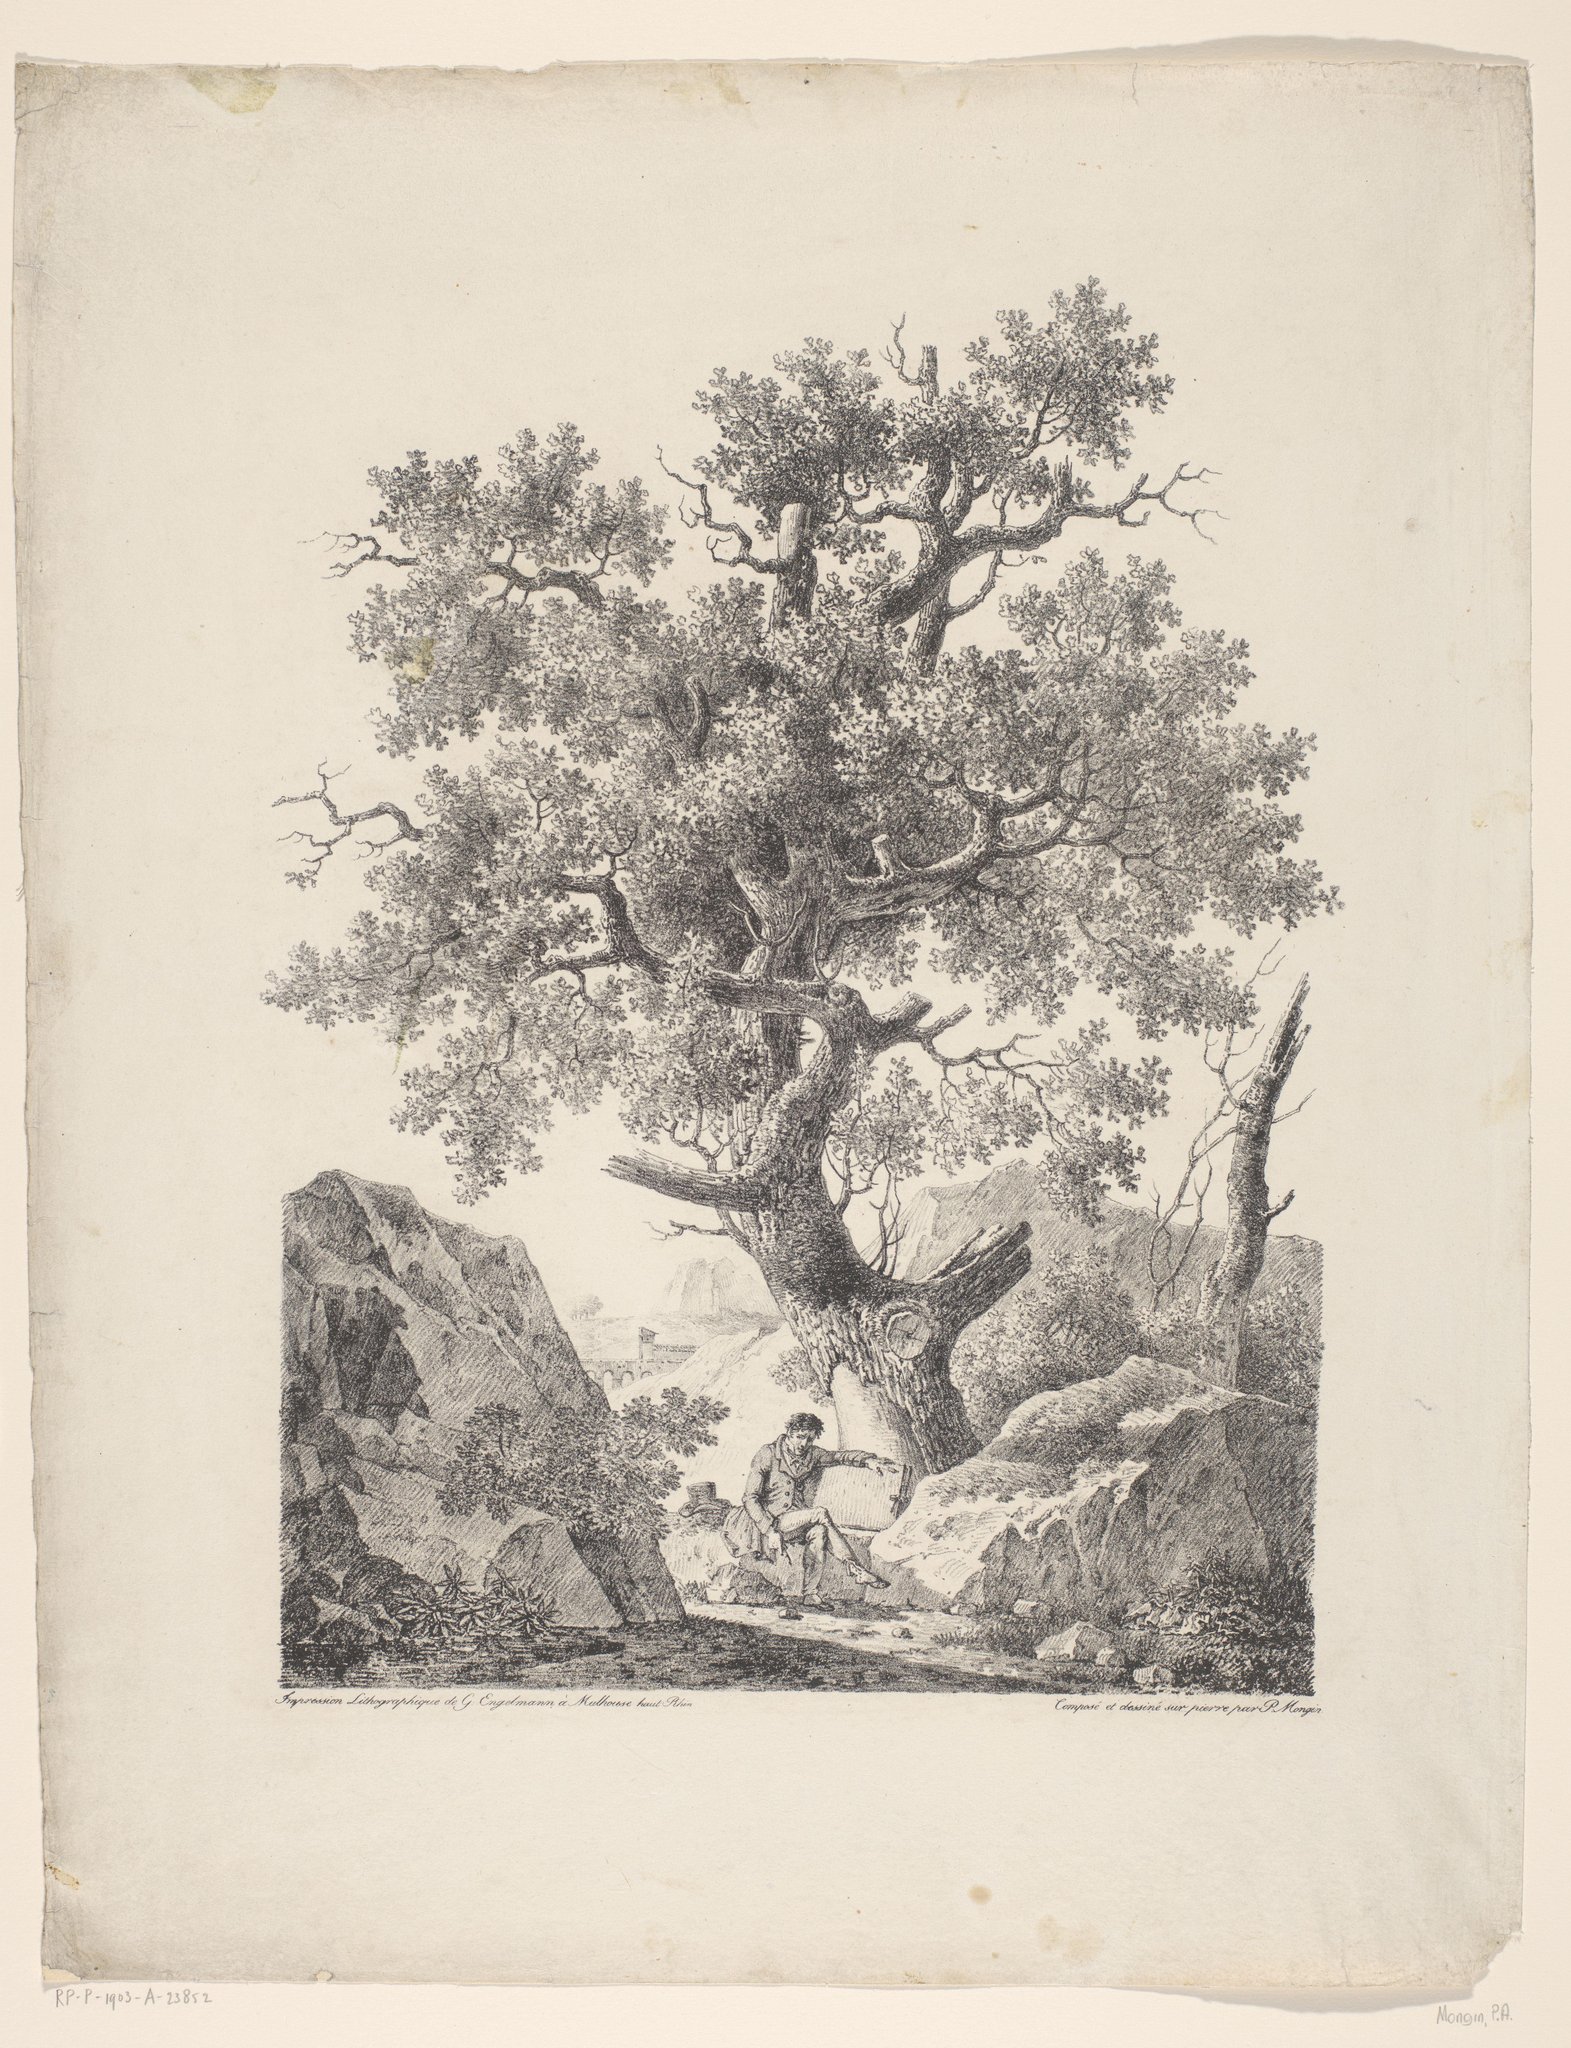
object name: print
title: Kunstenaar zittend onder een eikenboom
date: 1815-1823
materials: paper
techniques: lithograph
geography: mulhouse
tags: artist (in general) (+ artist at work), landscapes, trees: oak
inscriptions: collector's mark: Lugt 2228